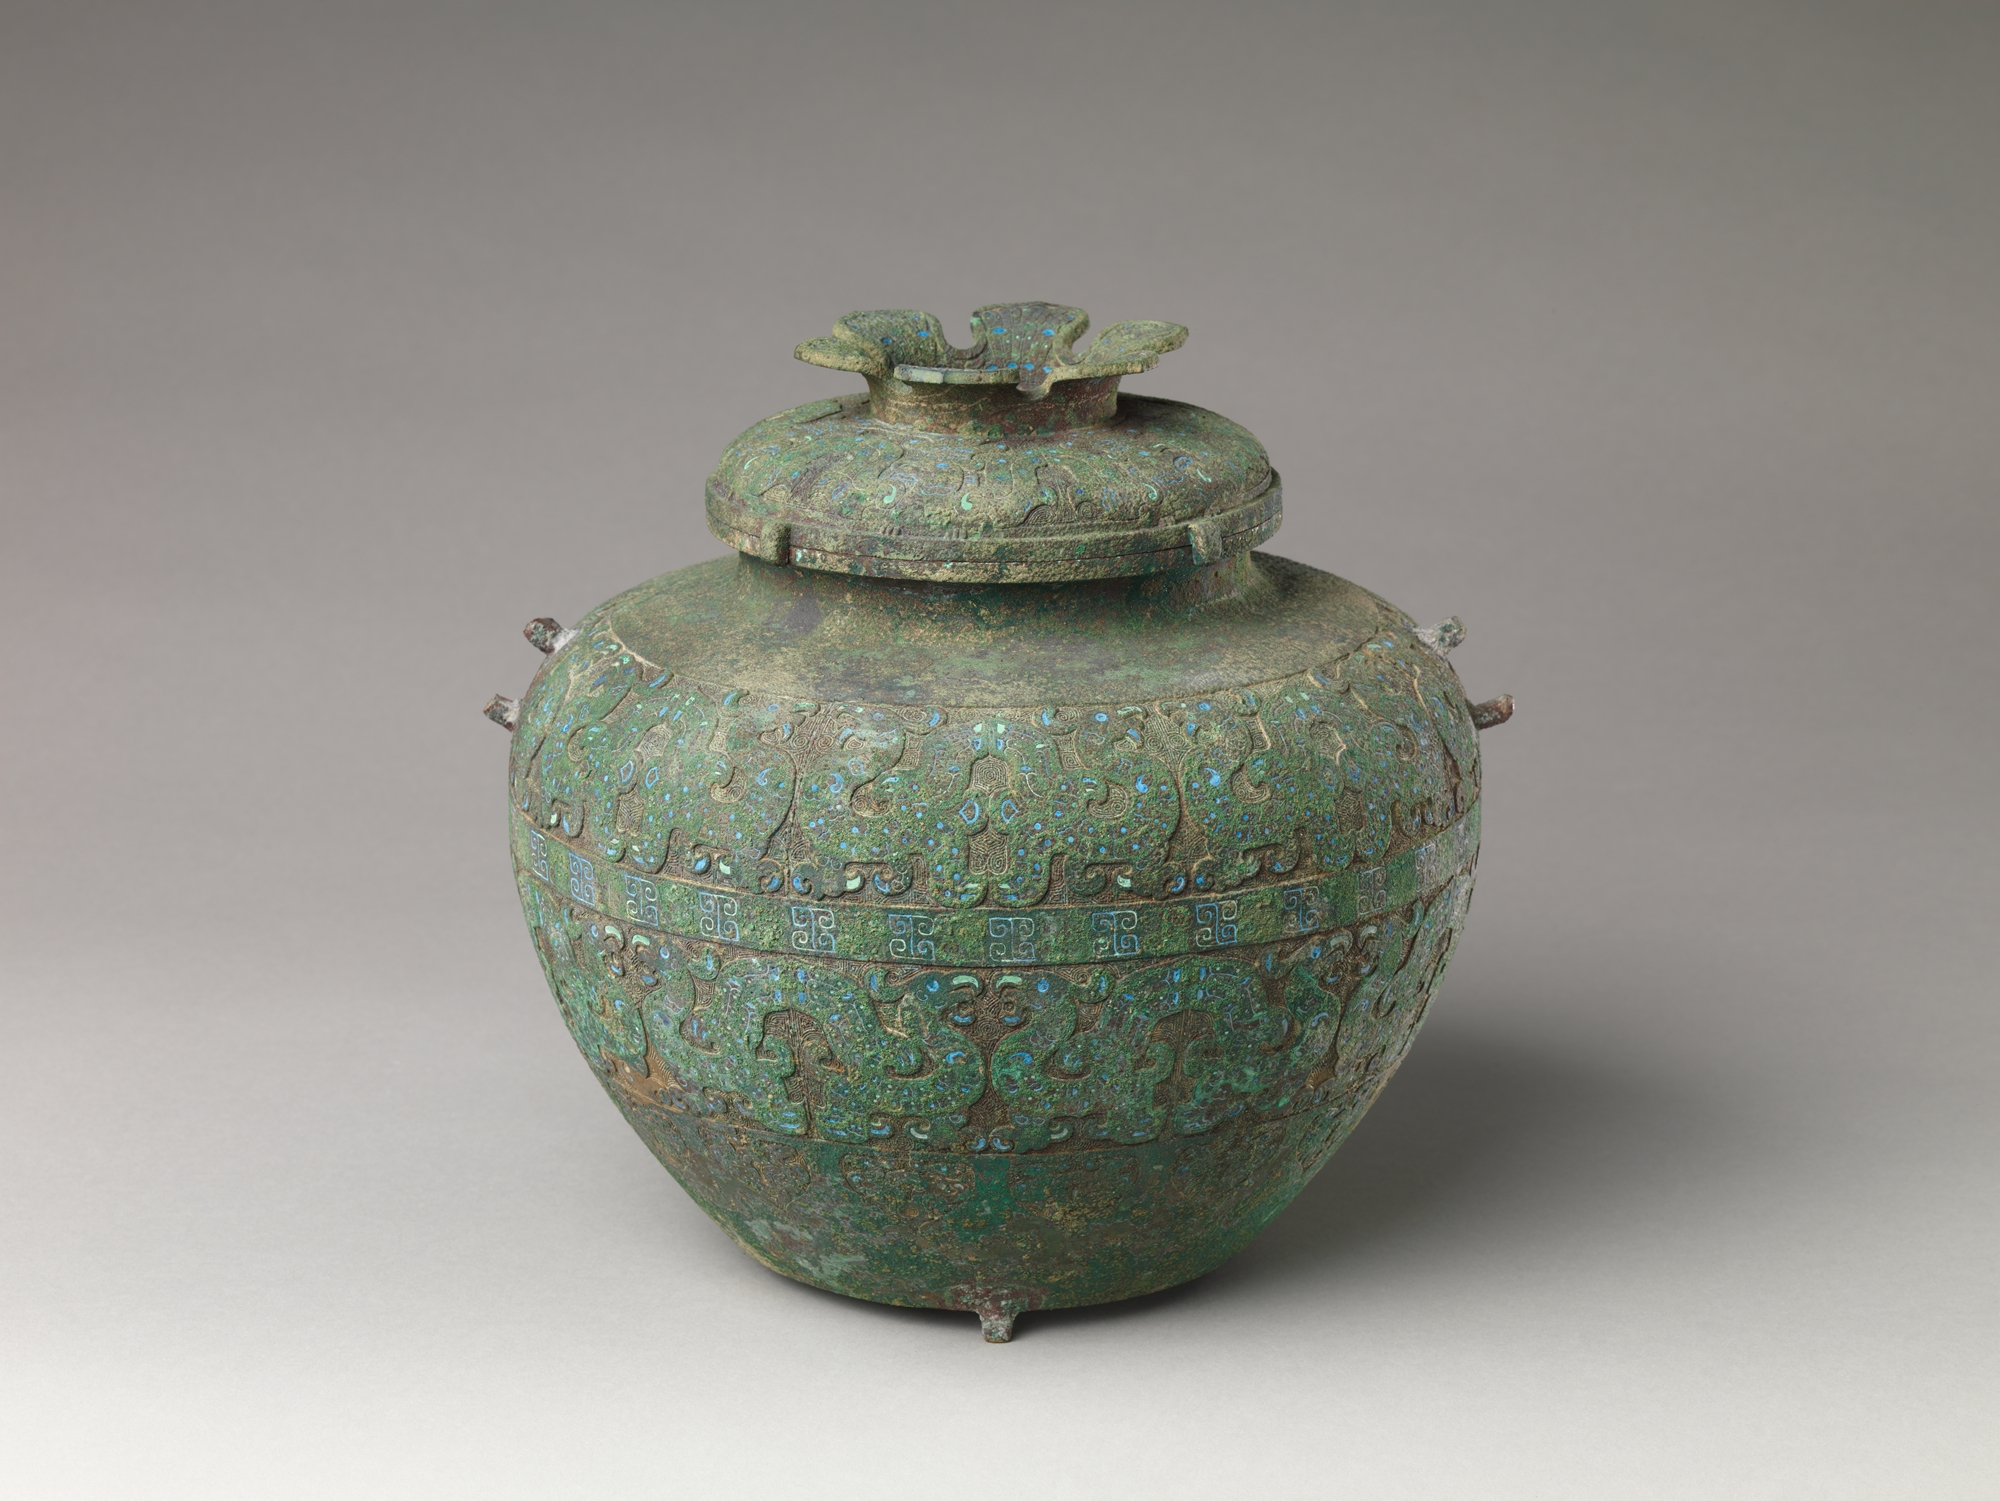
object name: wine container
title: Wine container (fou)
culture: chinese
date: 600-401 BCE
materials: bronze, pigment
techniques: inlay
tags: dragons